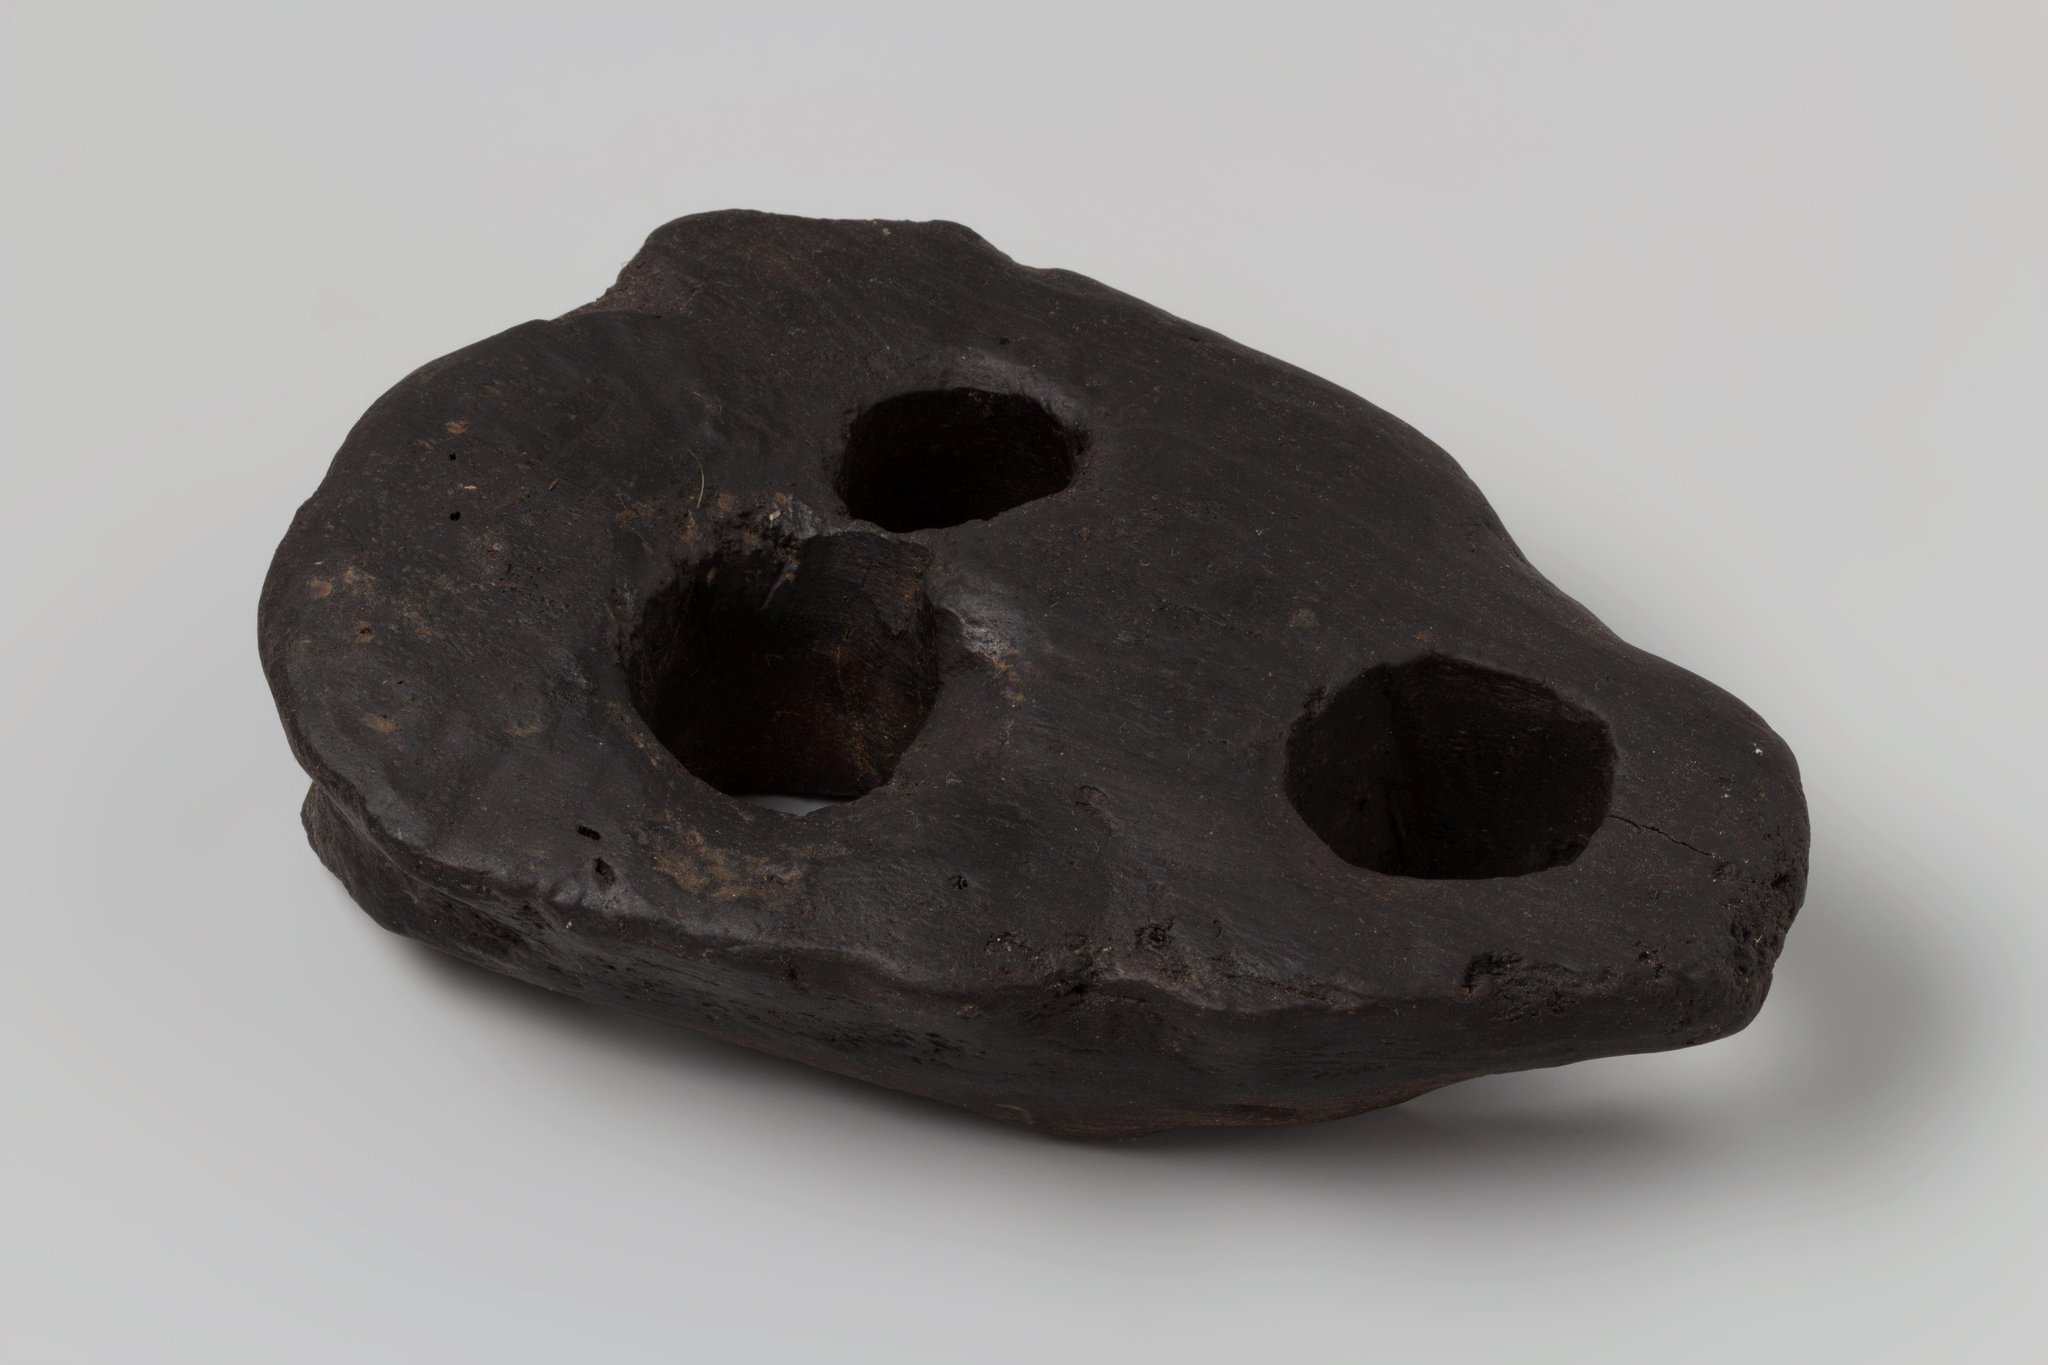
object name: jufferblok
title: Jufferblok uit V.O.C.-schip de 'Witte Leeuw'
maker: Anonymous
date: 1613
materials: wood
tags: verenigde oostindische compagnie, sint-helena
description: Jufferblok uit V.O.C.-schip de 'Witte Leeuw'.